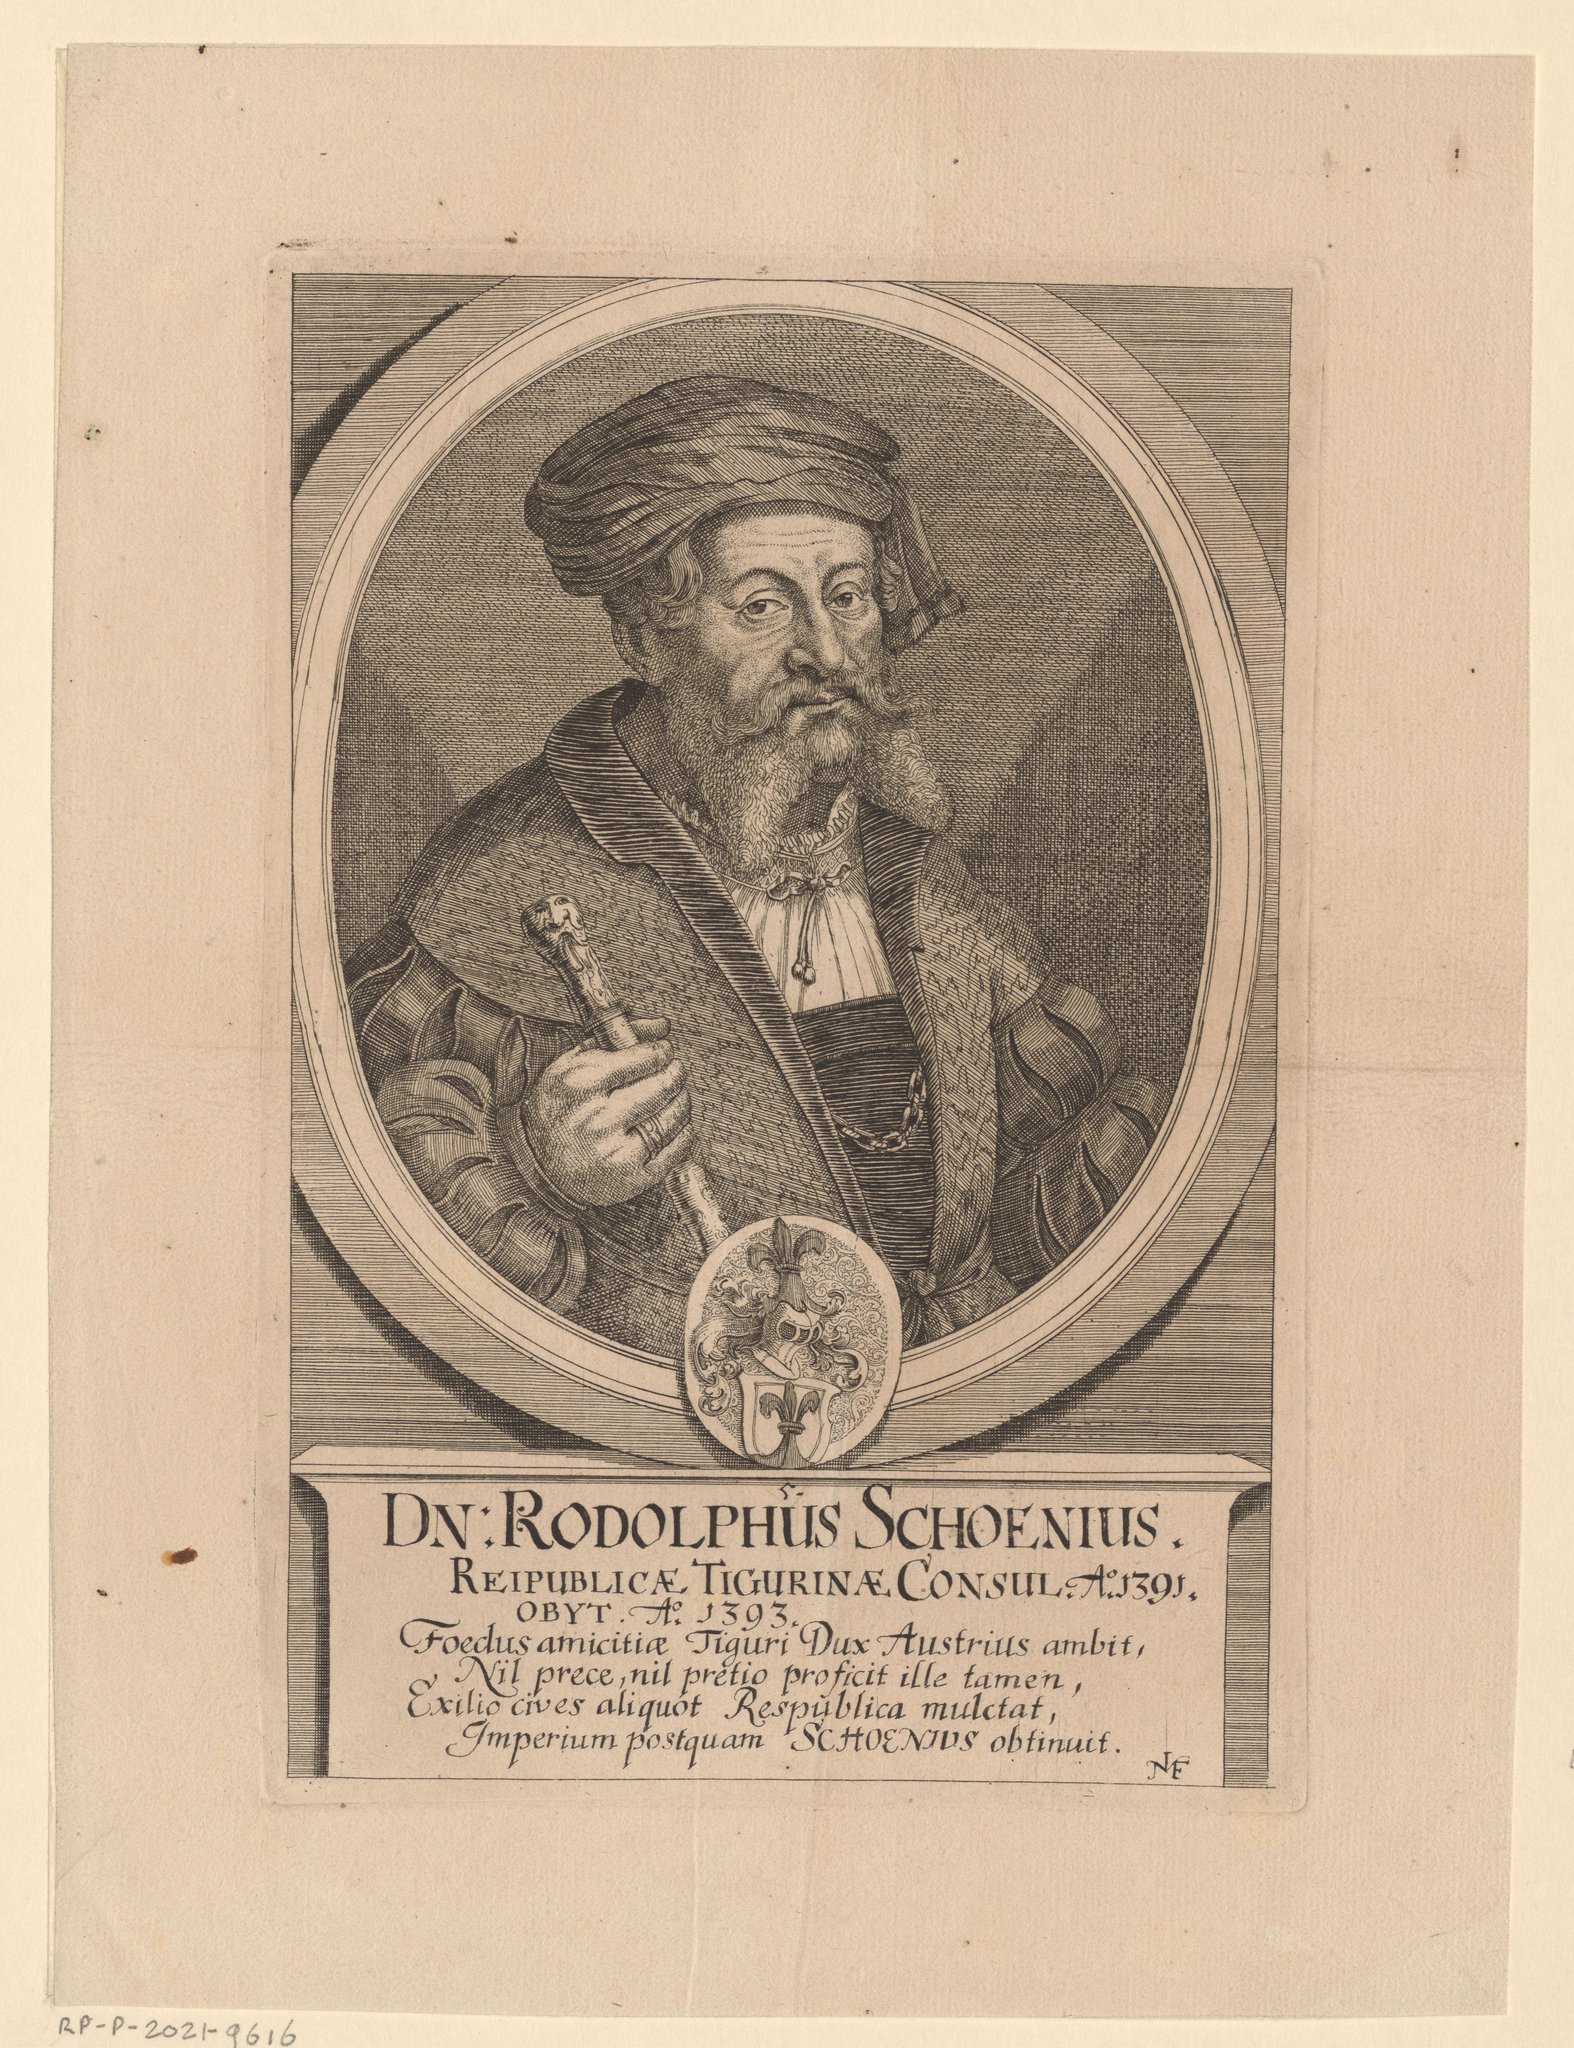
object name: print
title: Portretten van burgemeesters van Zürich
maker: johannes meyer (ii)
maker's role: print maker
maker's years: 1655-1712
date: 1665-1712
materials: paper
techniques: engraving, etching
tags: mayor, burgomaster, sceptre, staff (symbol of sovereignty), historical persons, armorial bearing, heraldry